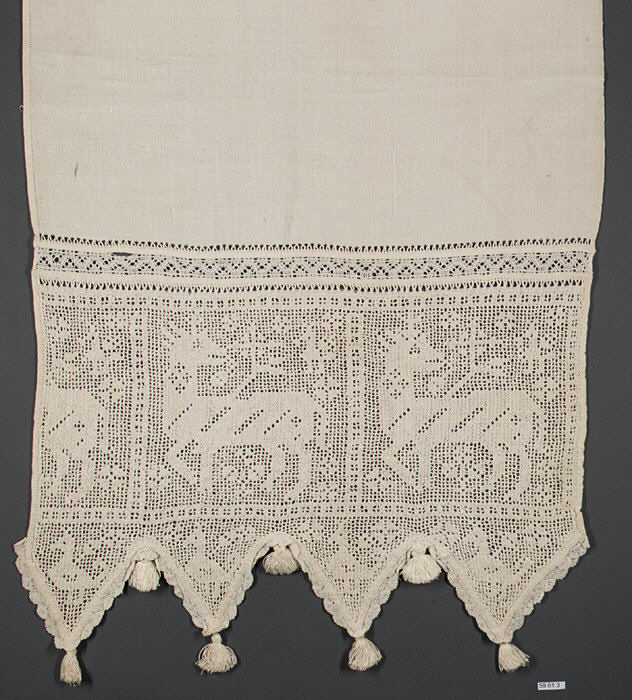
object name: towel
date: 1601-1700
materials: linen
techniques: lace, embroidery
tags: animals